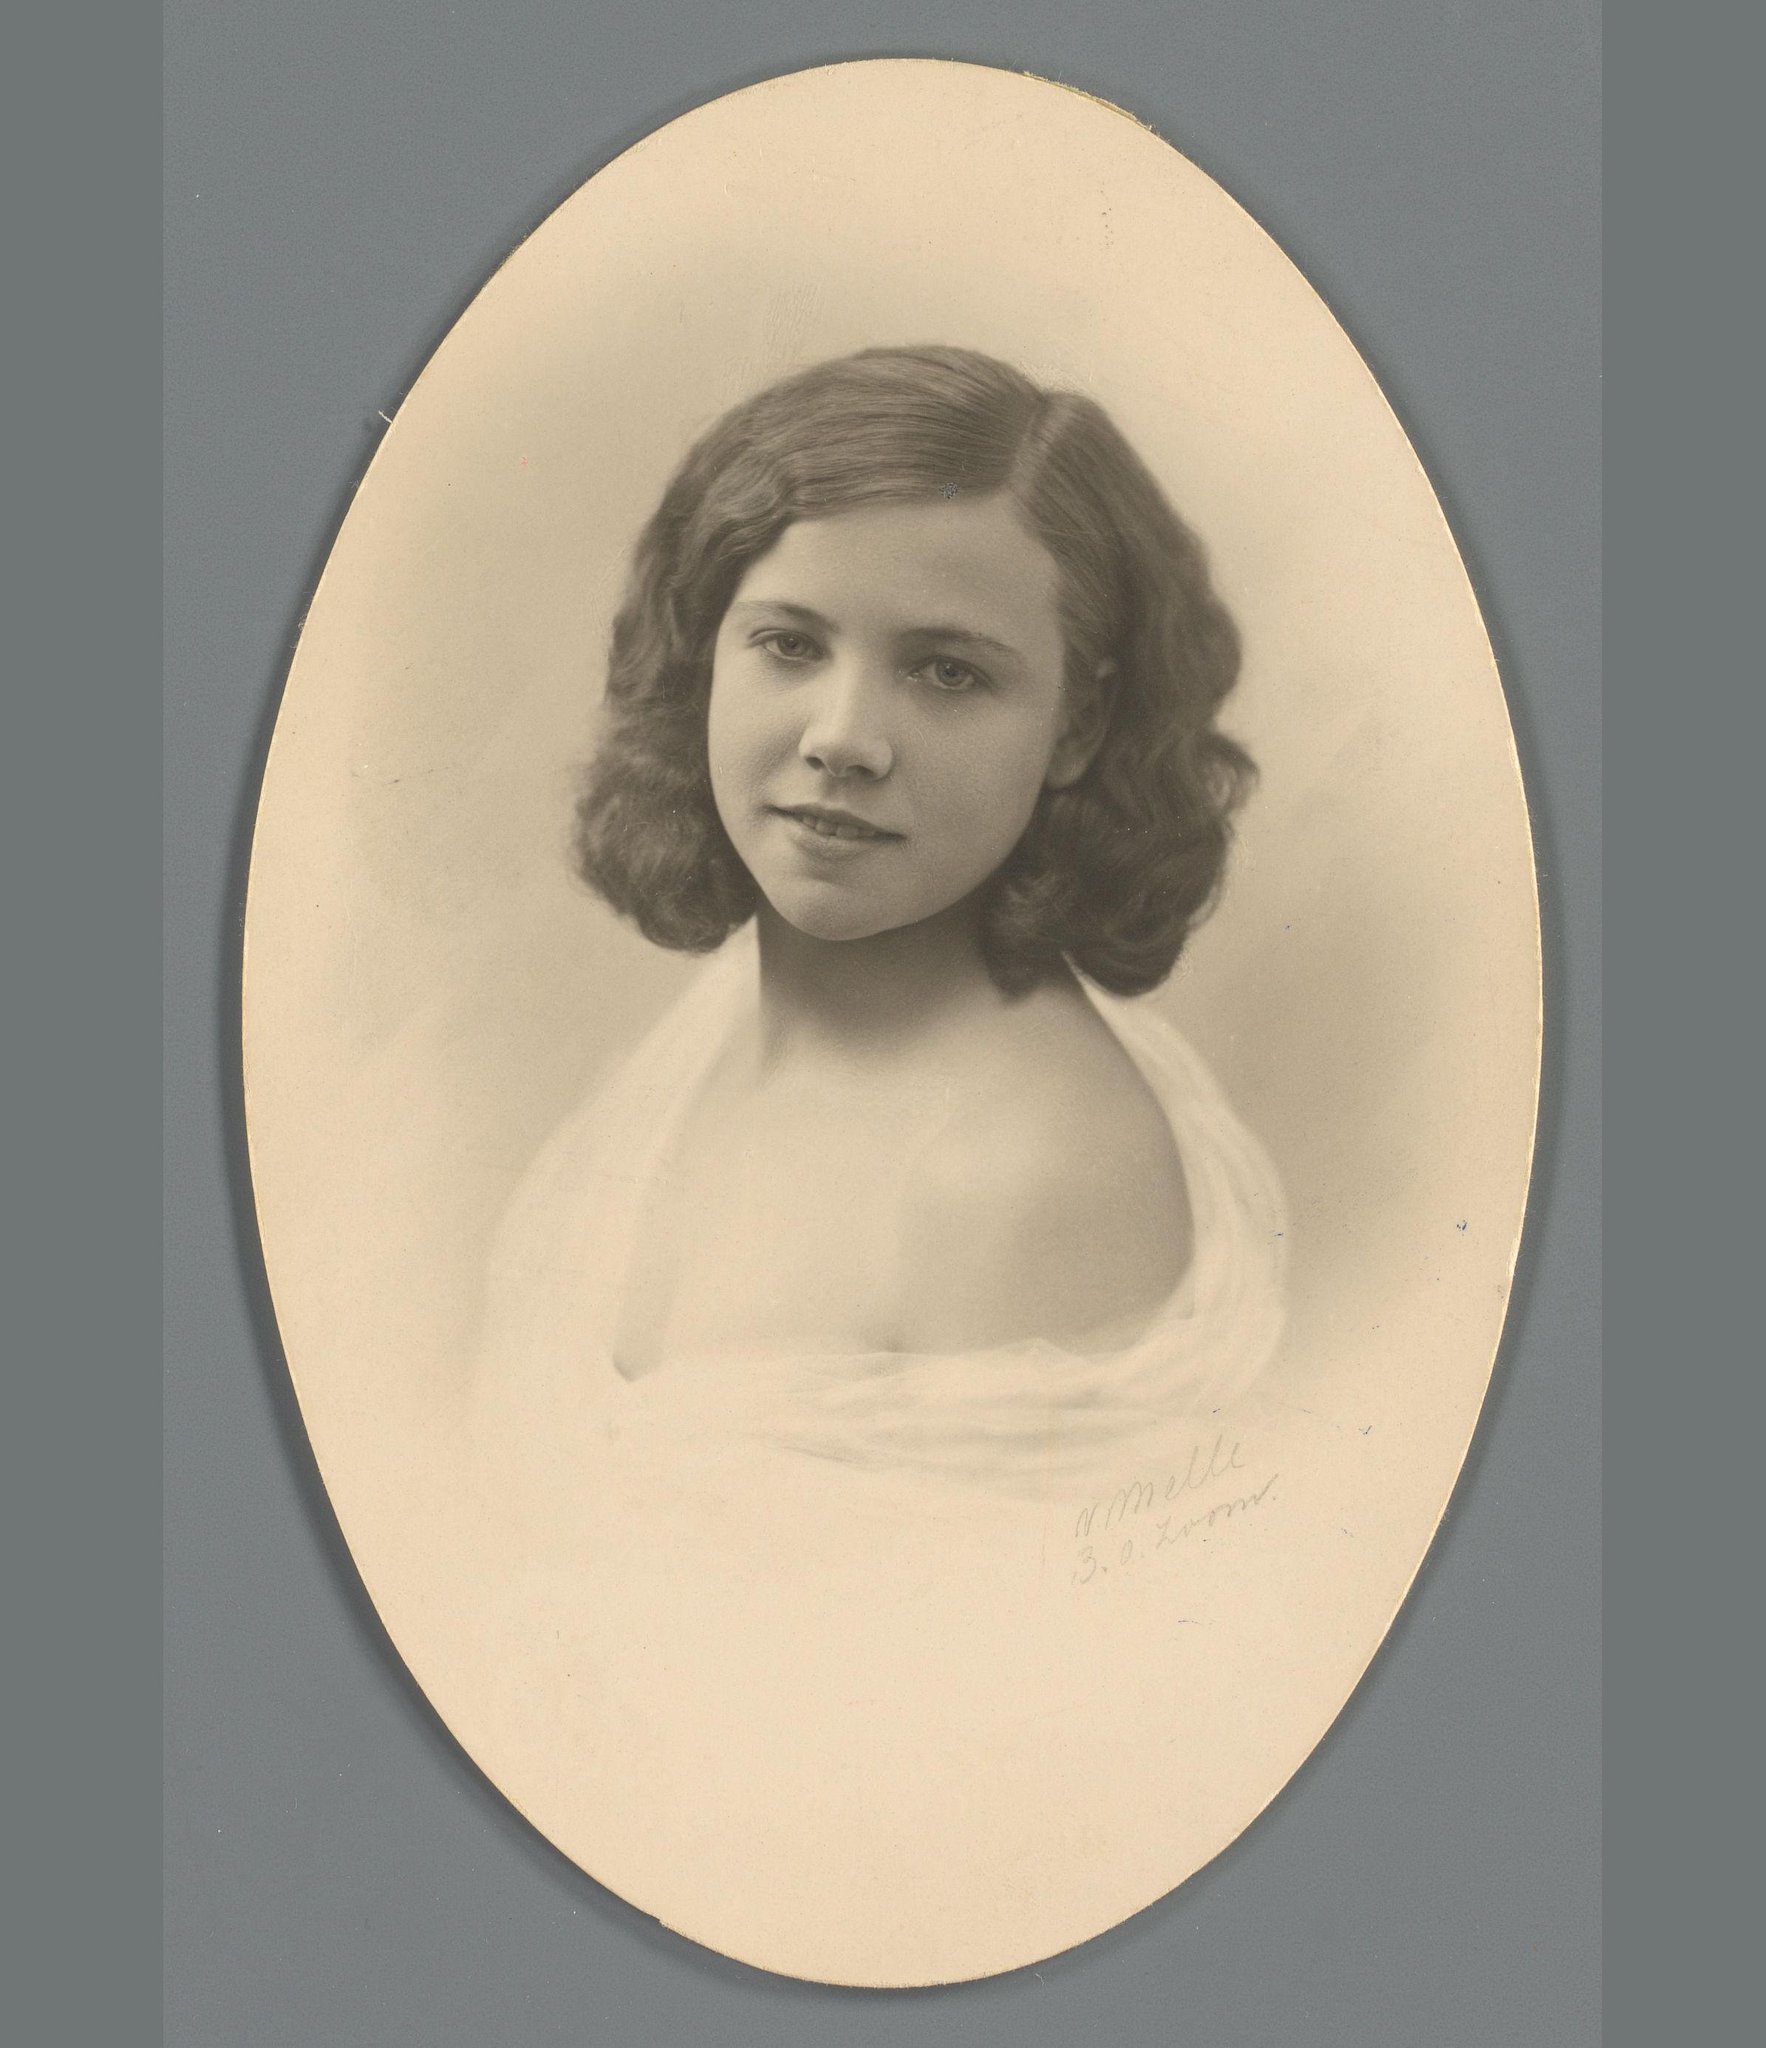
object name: photograph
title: Portret van Zulma Demeijer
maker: anthonie marinus van melle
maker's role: fotograaf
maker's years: 1870-1965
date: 1920-1930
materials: paper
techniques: gelatin silver print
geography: bergen op zoom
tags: historical persons - bb - woman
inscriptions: signature: ‘V. Melle/ B.o. Zoom’, inscription: ‘Zulma Merks’